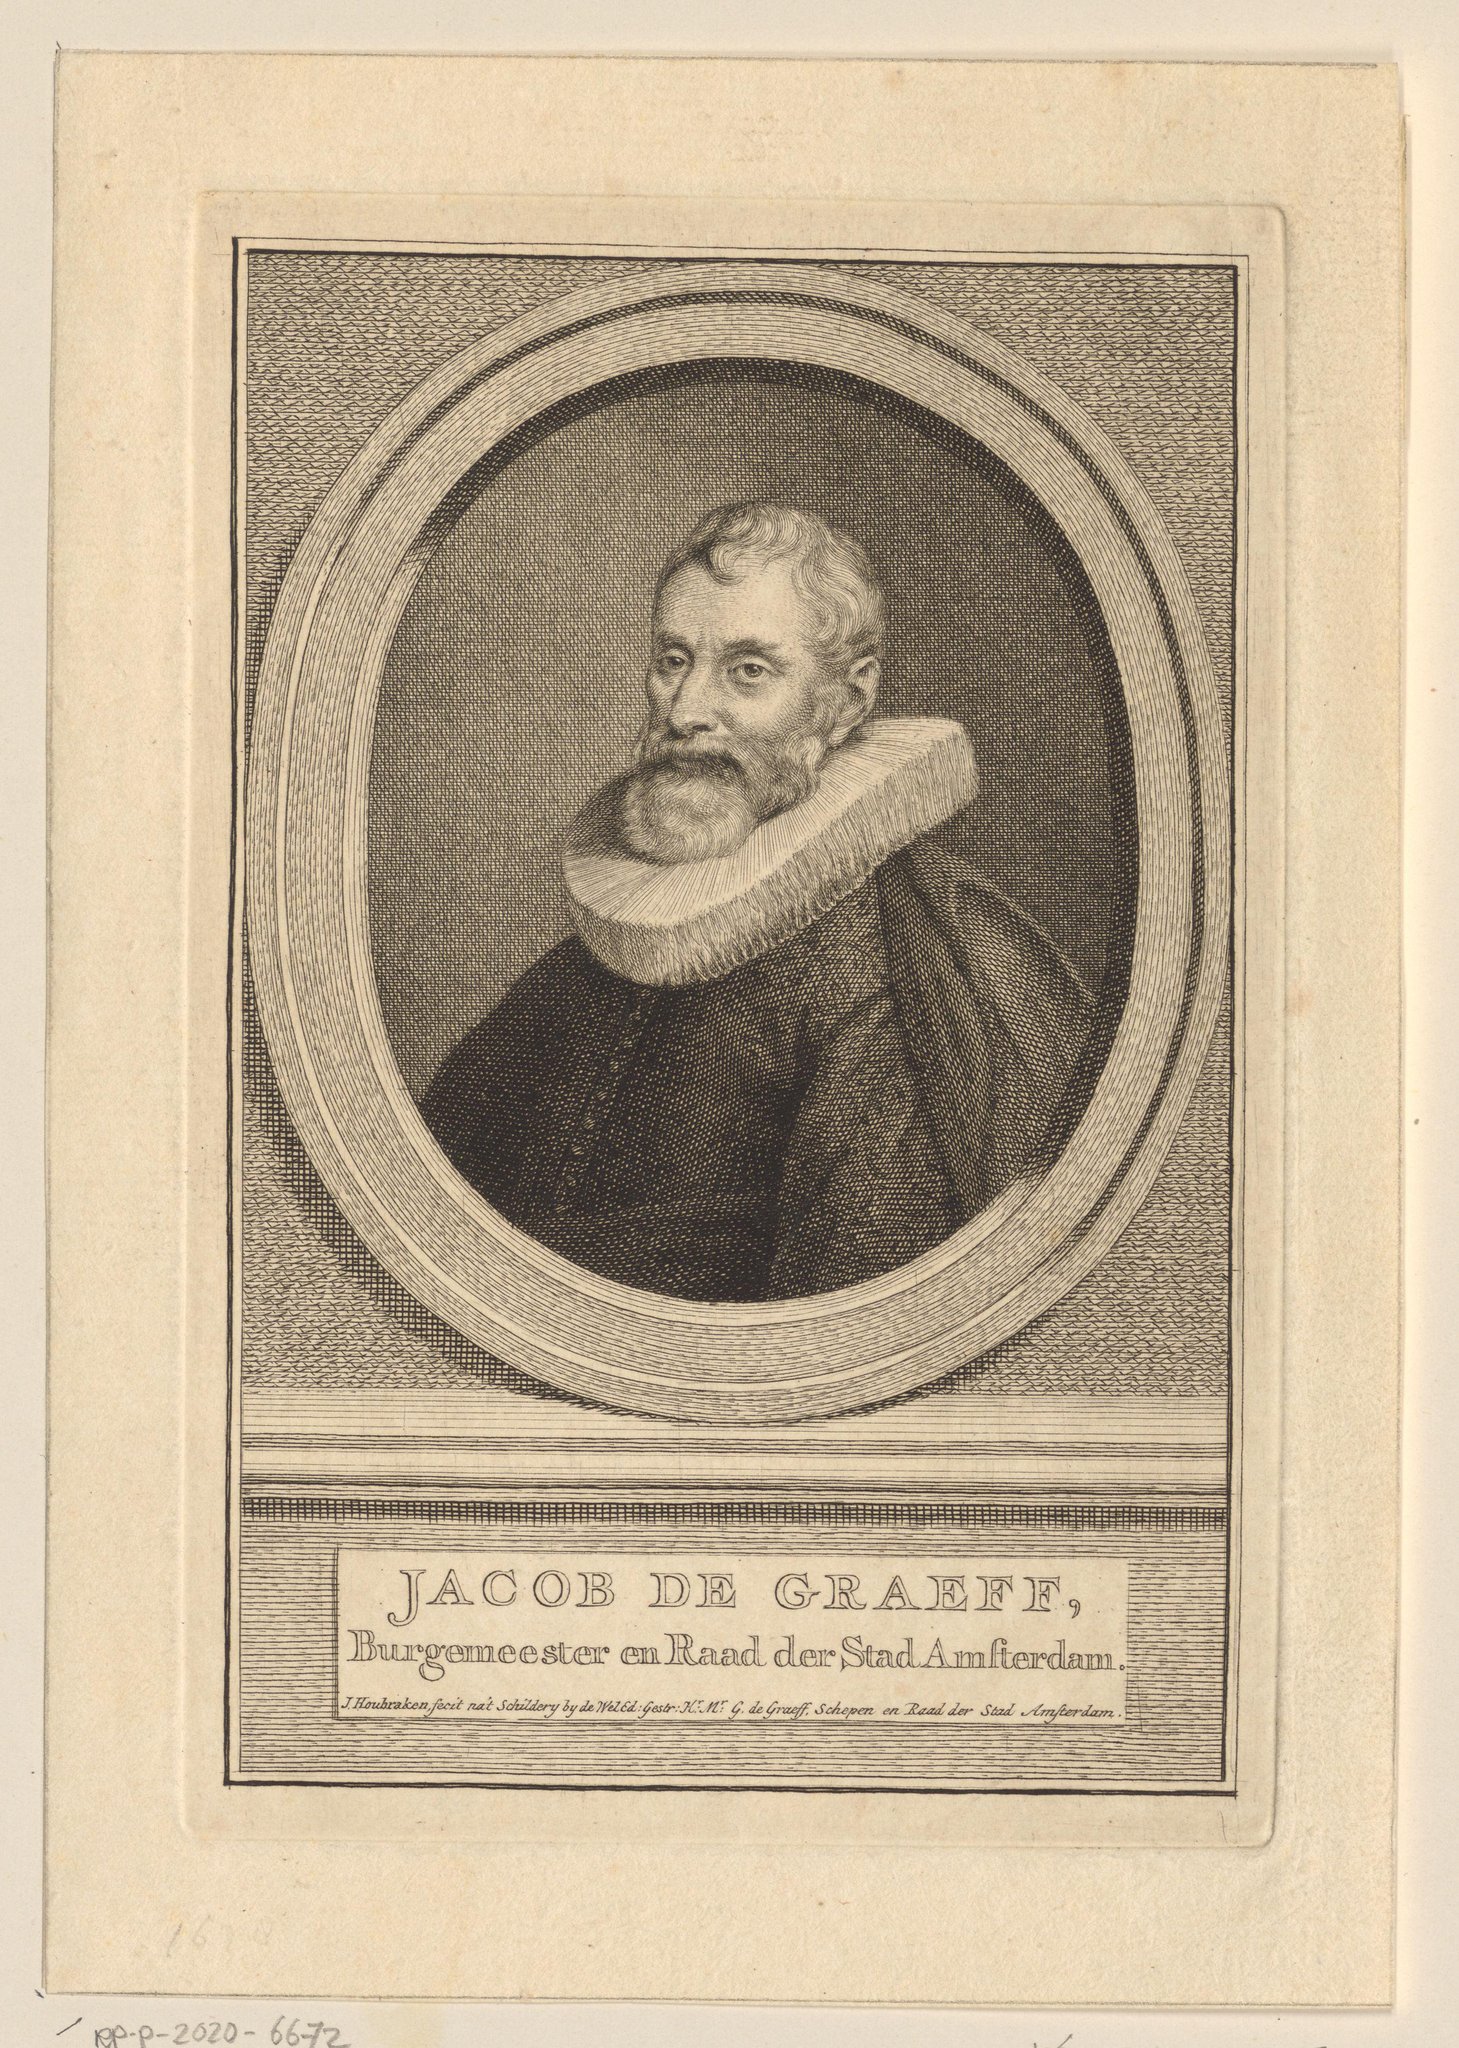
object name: print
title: Portret van Jacob Dirksz. de Graeff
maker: jacob houbraken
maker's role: draughtsman, print maker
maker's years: 1698-1780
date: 1749-1780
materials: paper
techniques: engraving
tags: mayor, burgomaster, historical persons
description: Deze prent is oorspronkelijk bedoeld als aanvulling op Jan Wagenaars ‘Vaderlandsche historie’ en was zo vanaf 1796 verkrijgbaar bij Johannes Allart te Amsterdam. Voor de advertentie waarin Allart de 60 portretten en 7 platen, allen gegraveerd door Houbraken, ter aanvulling op Wagenaars ‘Vaderlandsche historie’ aanbiedt, zie RP-P-OB-77.766. Van dit werk zijn meerdere uitgaves verschenen. Prent uit: Wagenaar, Jan. Vaderlandsche historie, vervattende de geschiedenissen der Vereenigde Nederlanden (…). 21 dln. Amsterdam: Isaak Tirion, 1749-1759. Prent ook gebruikt in: Wagenaar, Jan. Vaderlandsche historie, vervattende de geschiedenissen der nu Vereenigde Nederlanden (…). 21 dln. Amsterdam: weduwe Isaak Tirion, 1770. Prent ook gebruikt in: Wagenaar, Jan. Vaderlandsche historie, vervattende de geschiedenissen der nu Vereenigde Nederlanden (…). 21 dln. Amsterdam, Leiden, Dordrecht en Harlingen: P. Schouten et al., 1782. Prent ook gebruikt in: Wagenaar, Jan. Vaderlandsche historie, vervattende de geschiedenissen der nu Vereenigde Nederlanden (…). 21 dln. Amsterdam: Johannes Allart, 1790-1796.